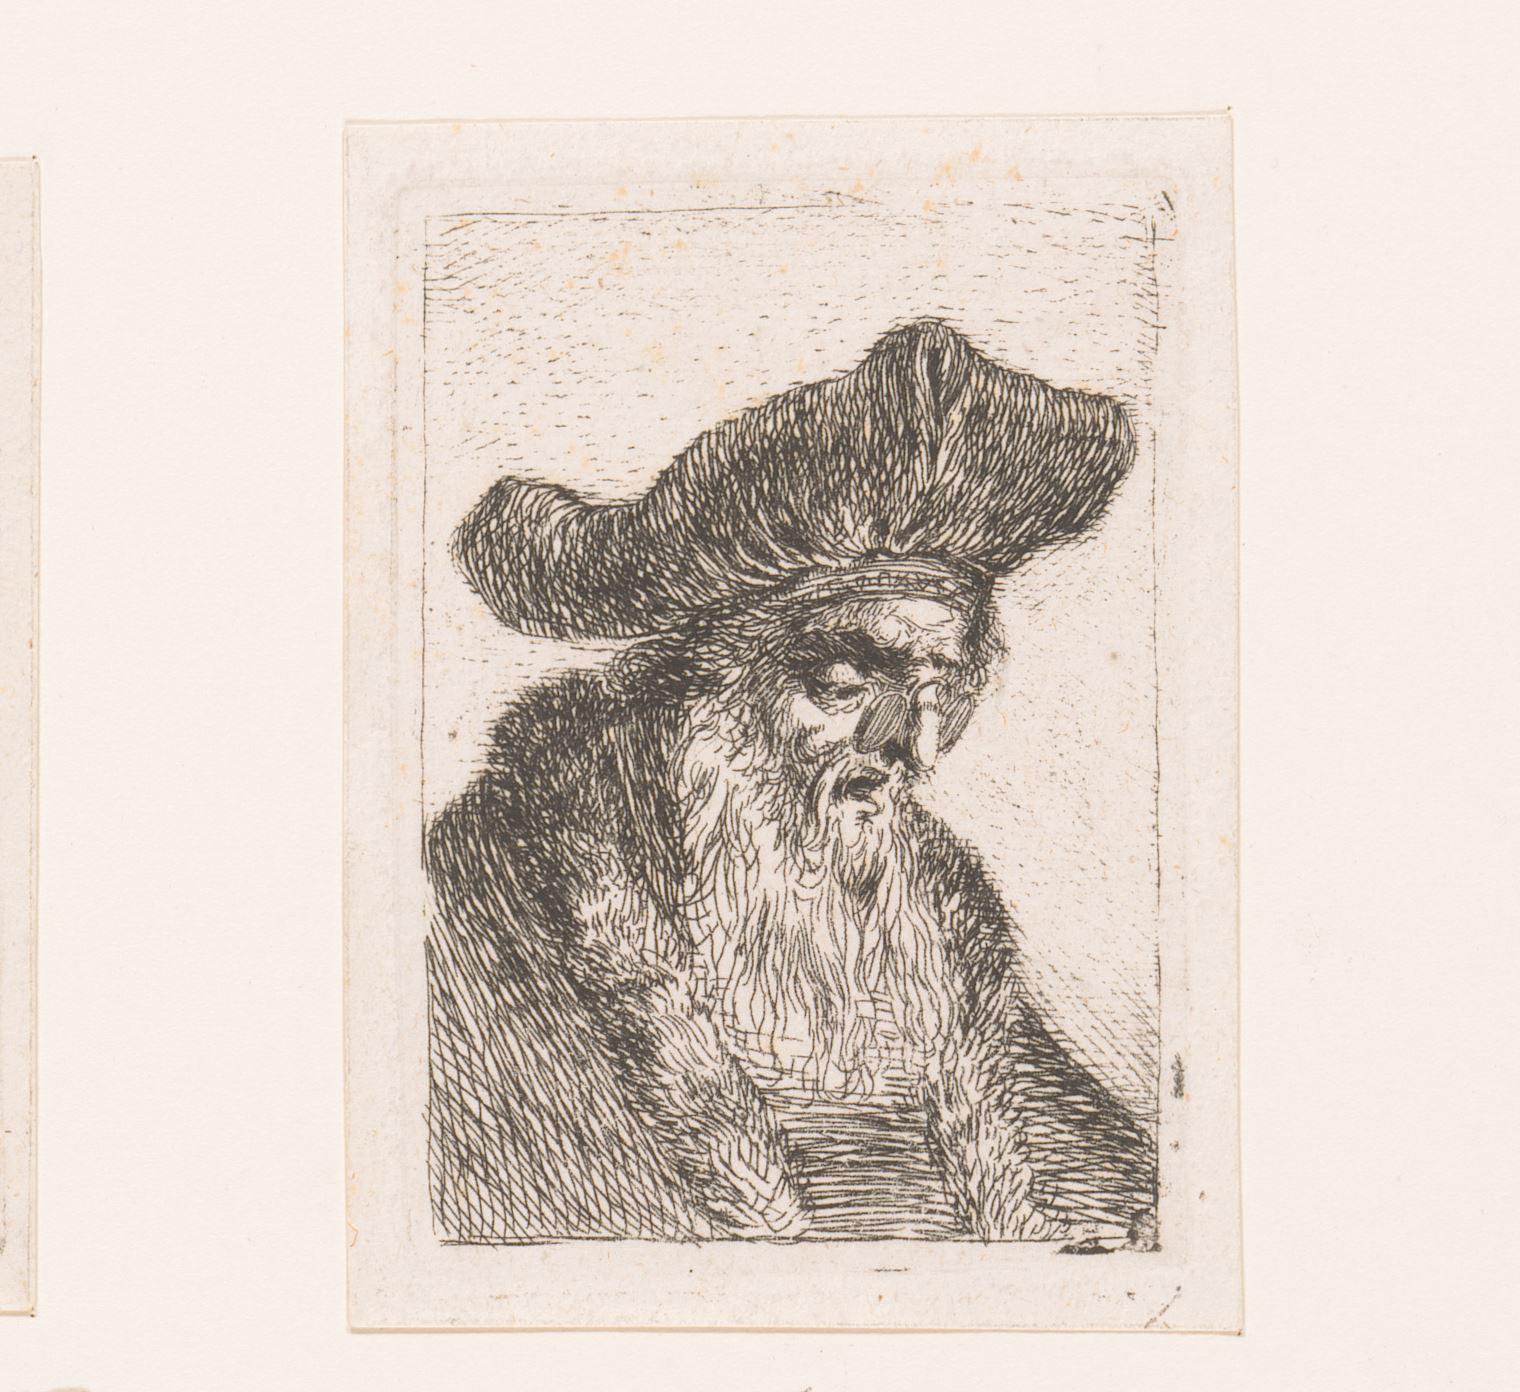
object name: print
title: Kop van man met baard en bril, met een bontkraag en grote baret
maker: Anonymous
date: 1700-1799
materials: paper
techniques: etching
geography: germany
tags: old man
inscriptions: collector's mark: Lugt 240